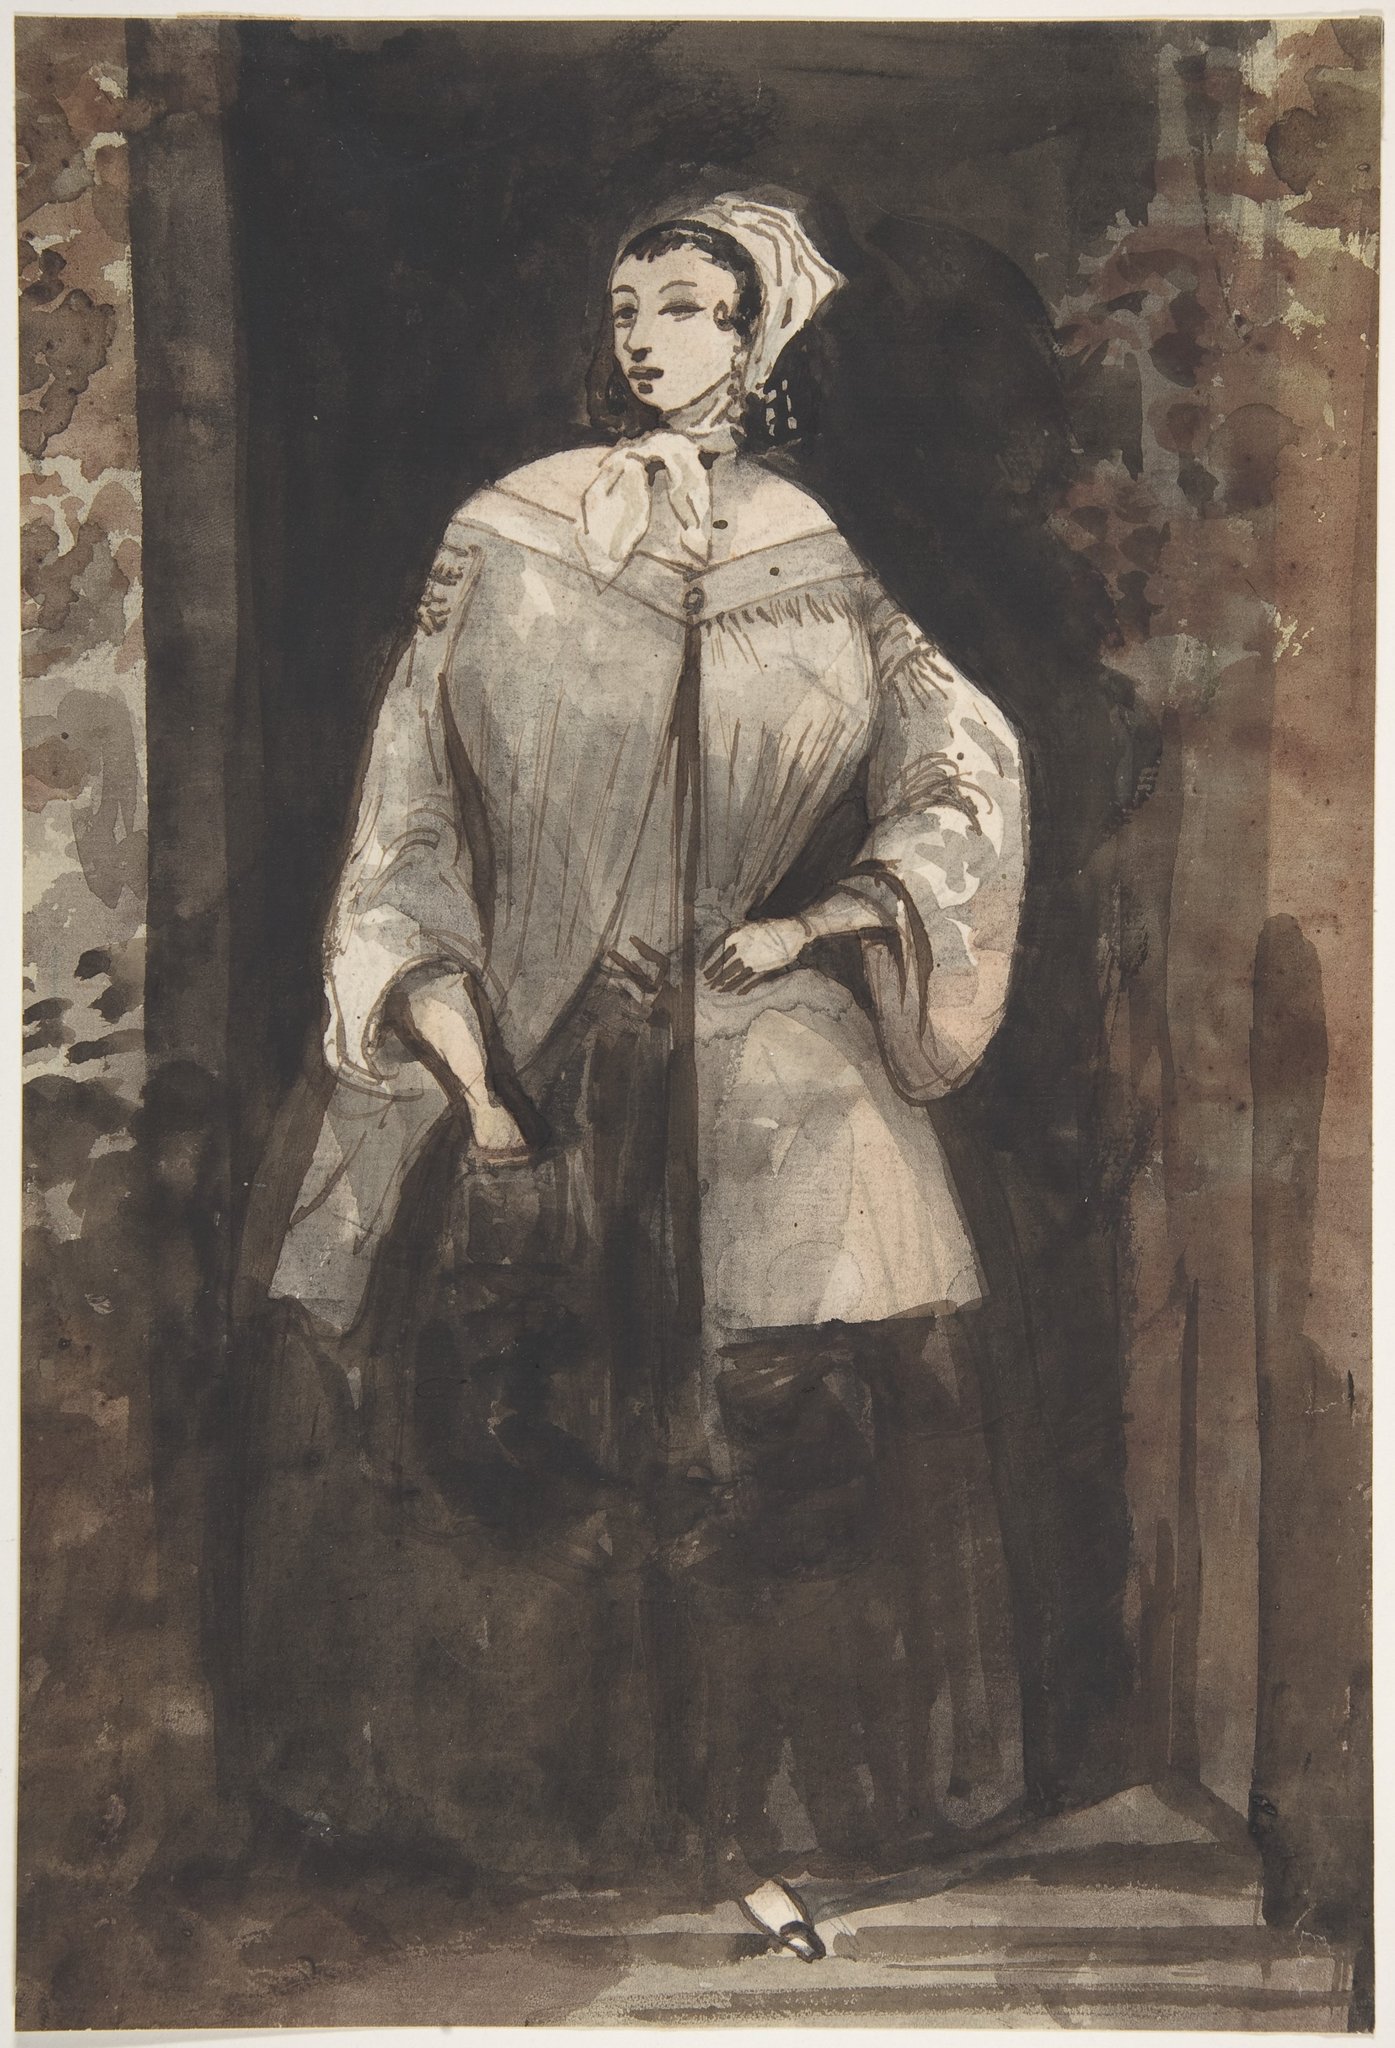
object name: drawing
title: Woman Standing in a Doorway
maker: constantin guys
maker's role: artist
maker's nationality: french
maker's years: 1802-1892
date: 1801-1900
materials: graphite, ink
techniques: pen, wash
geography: france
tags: women